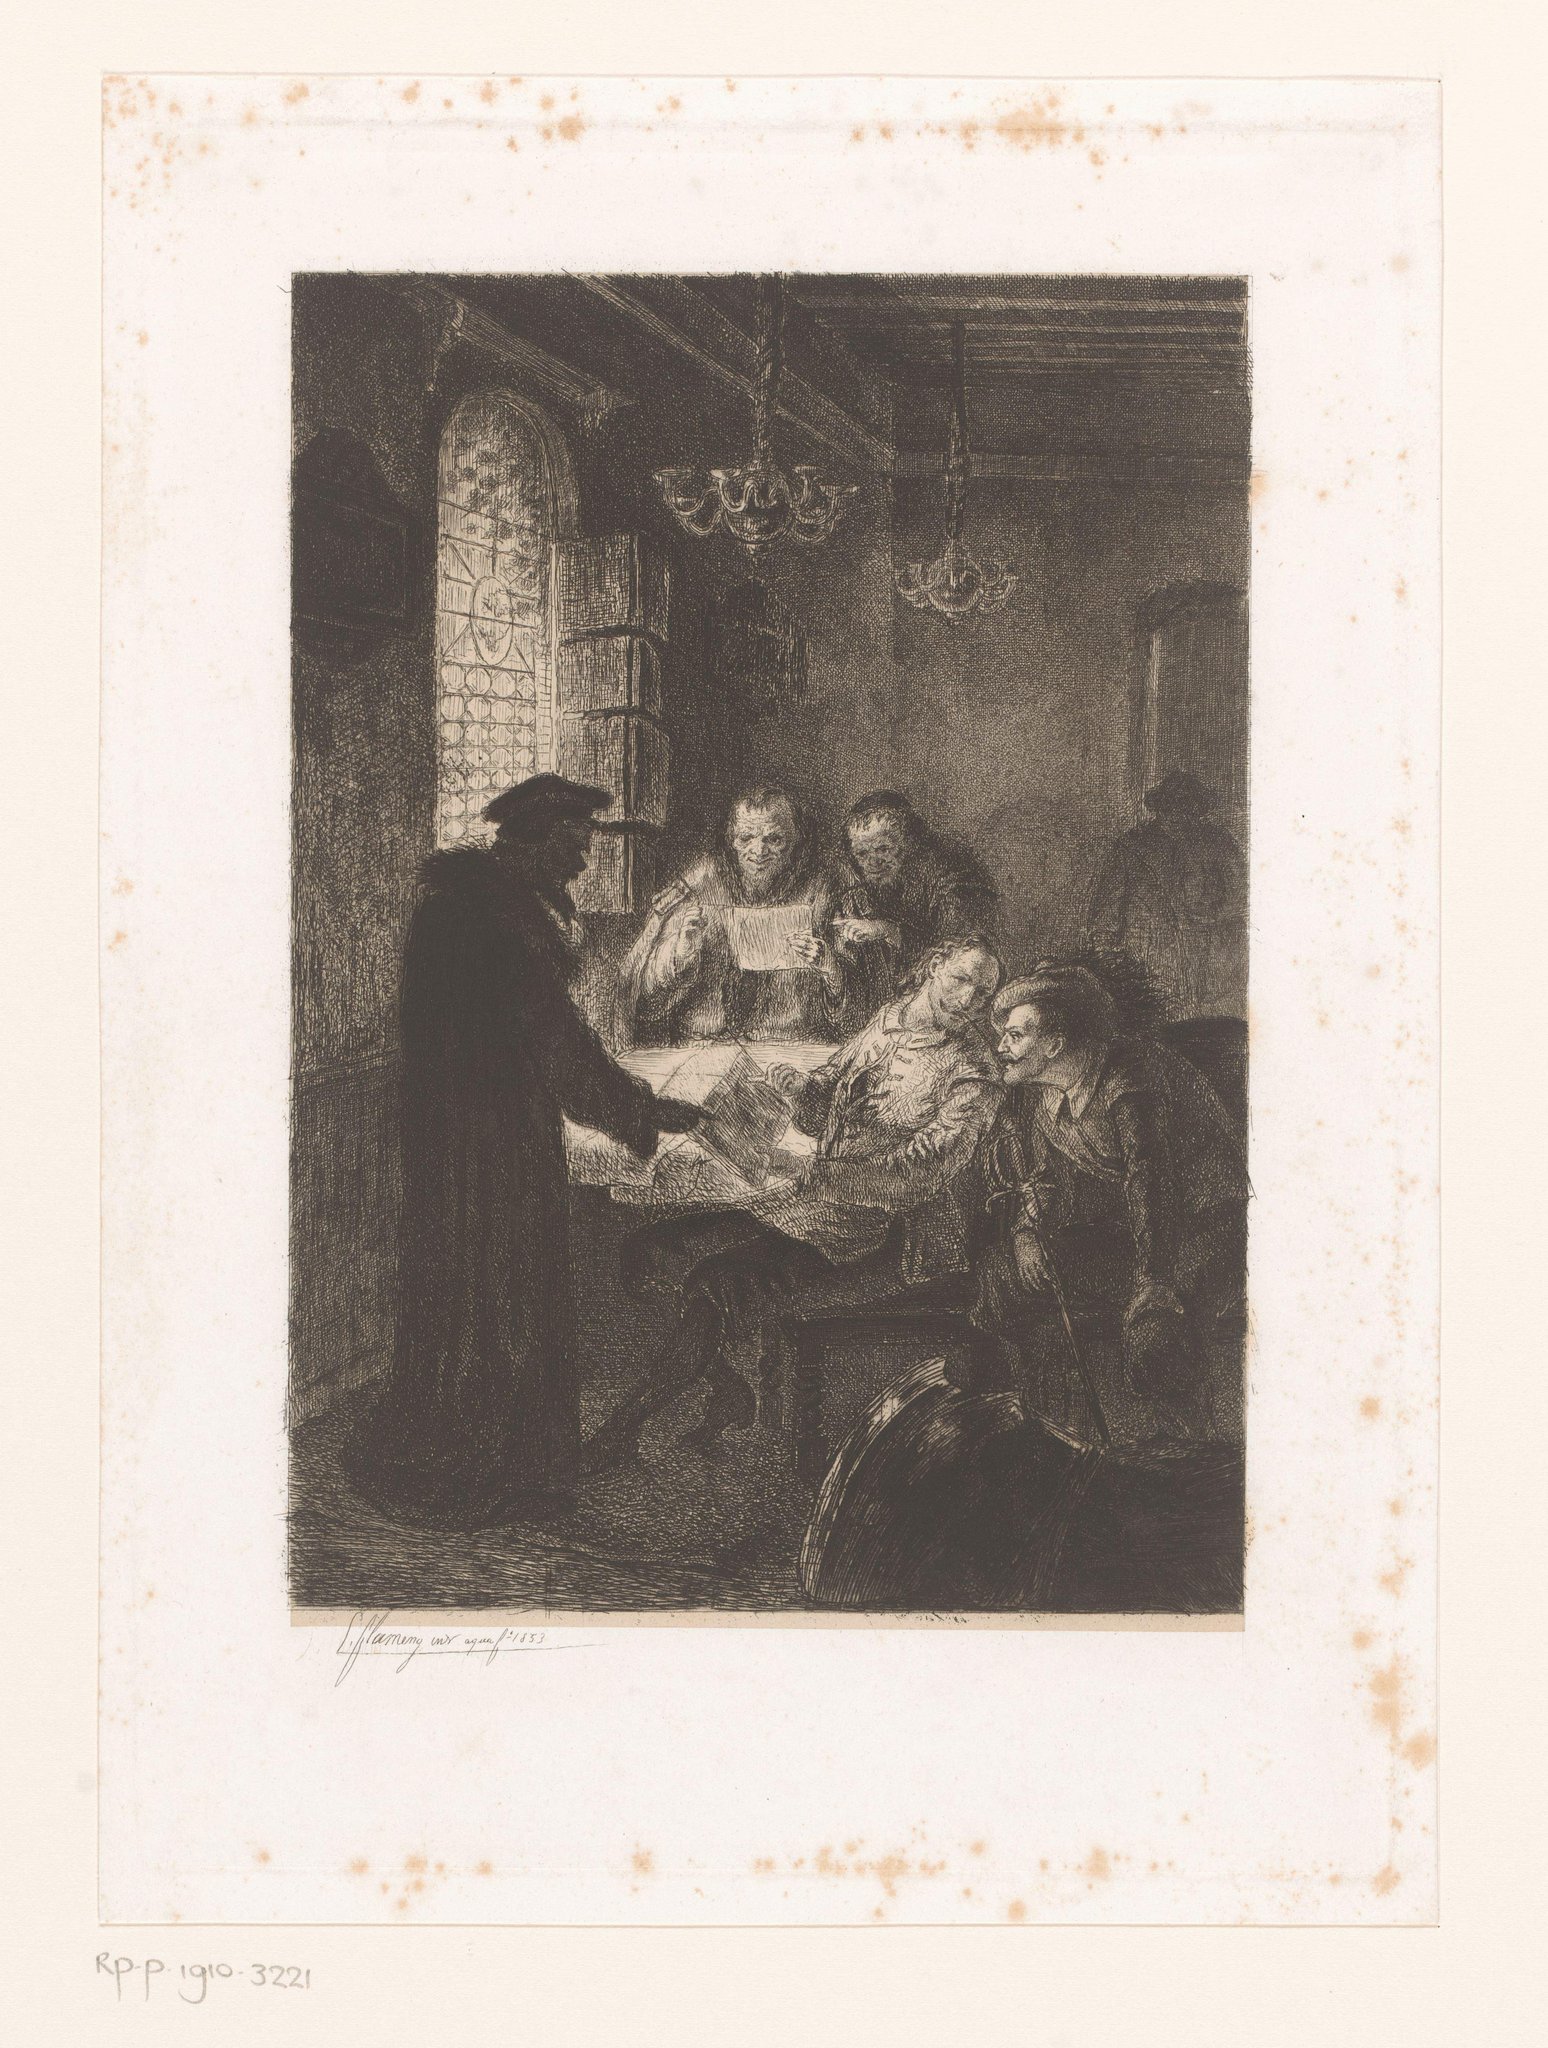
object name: print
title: Groep in renaissance kledij rond een tafel bestuderen brieven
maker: léopold flameng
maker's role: print maker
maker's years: 1831-1911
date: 1853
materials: paper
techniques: drypoint, etching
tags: reading to somebody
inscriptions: collector's mark: Lugt 2228, collector's mark: Lugt 1485